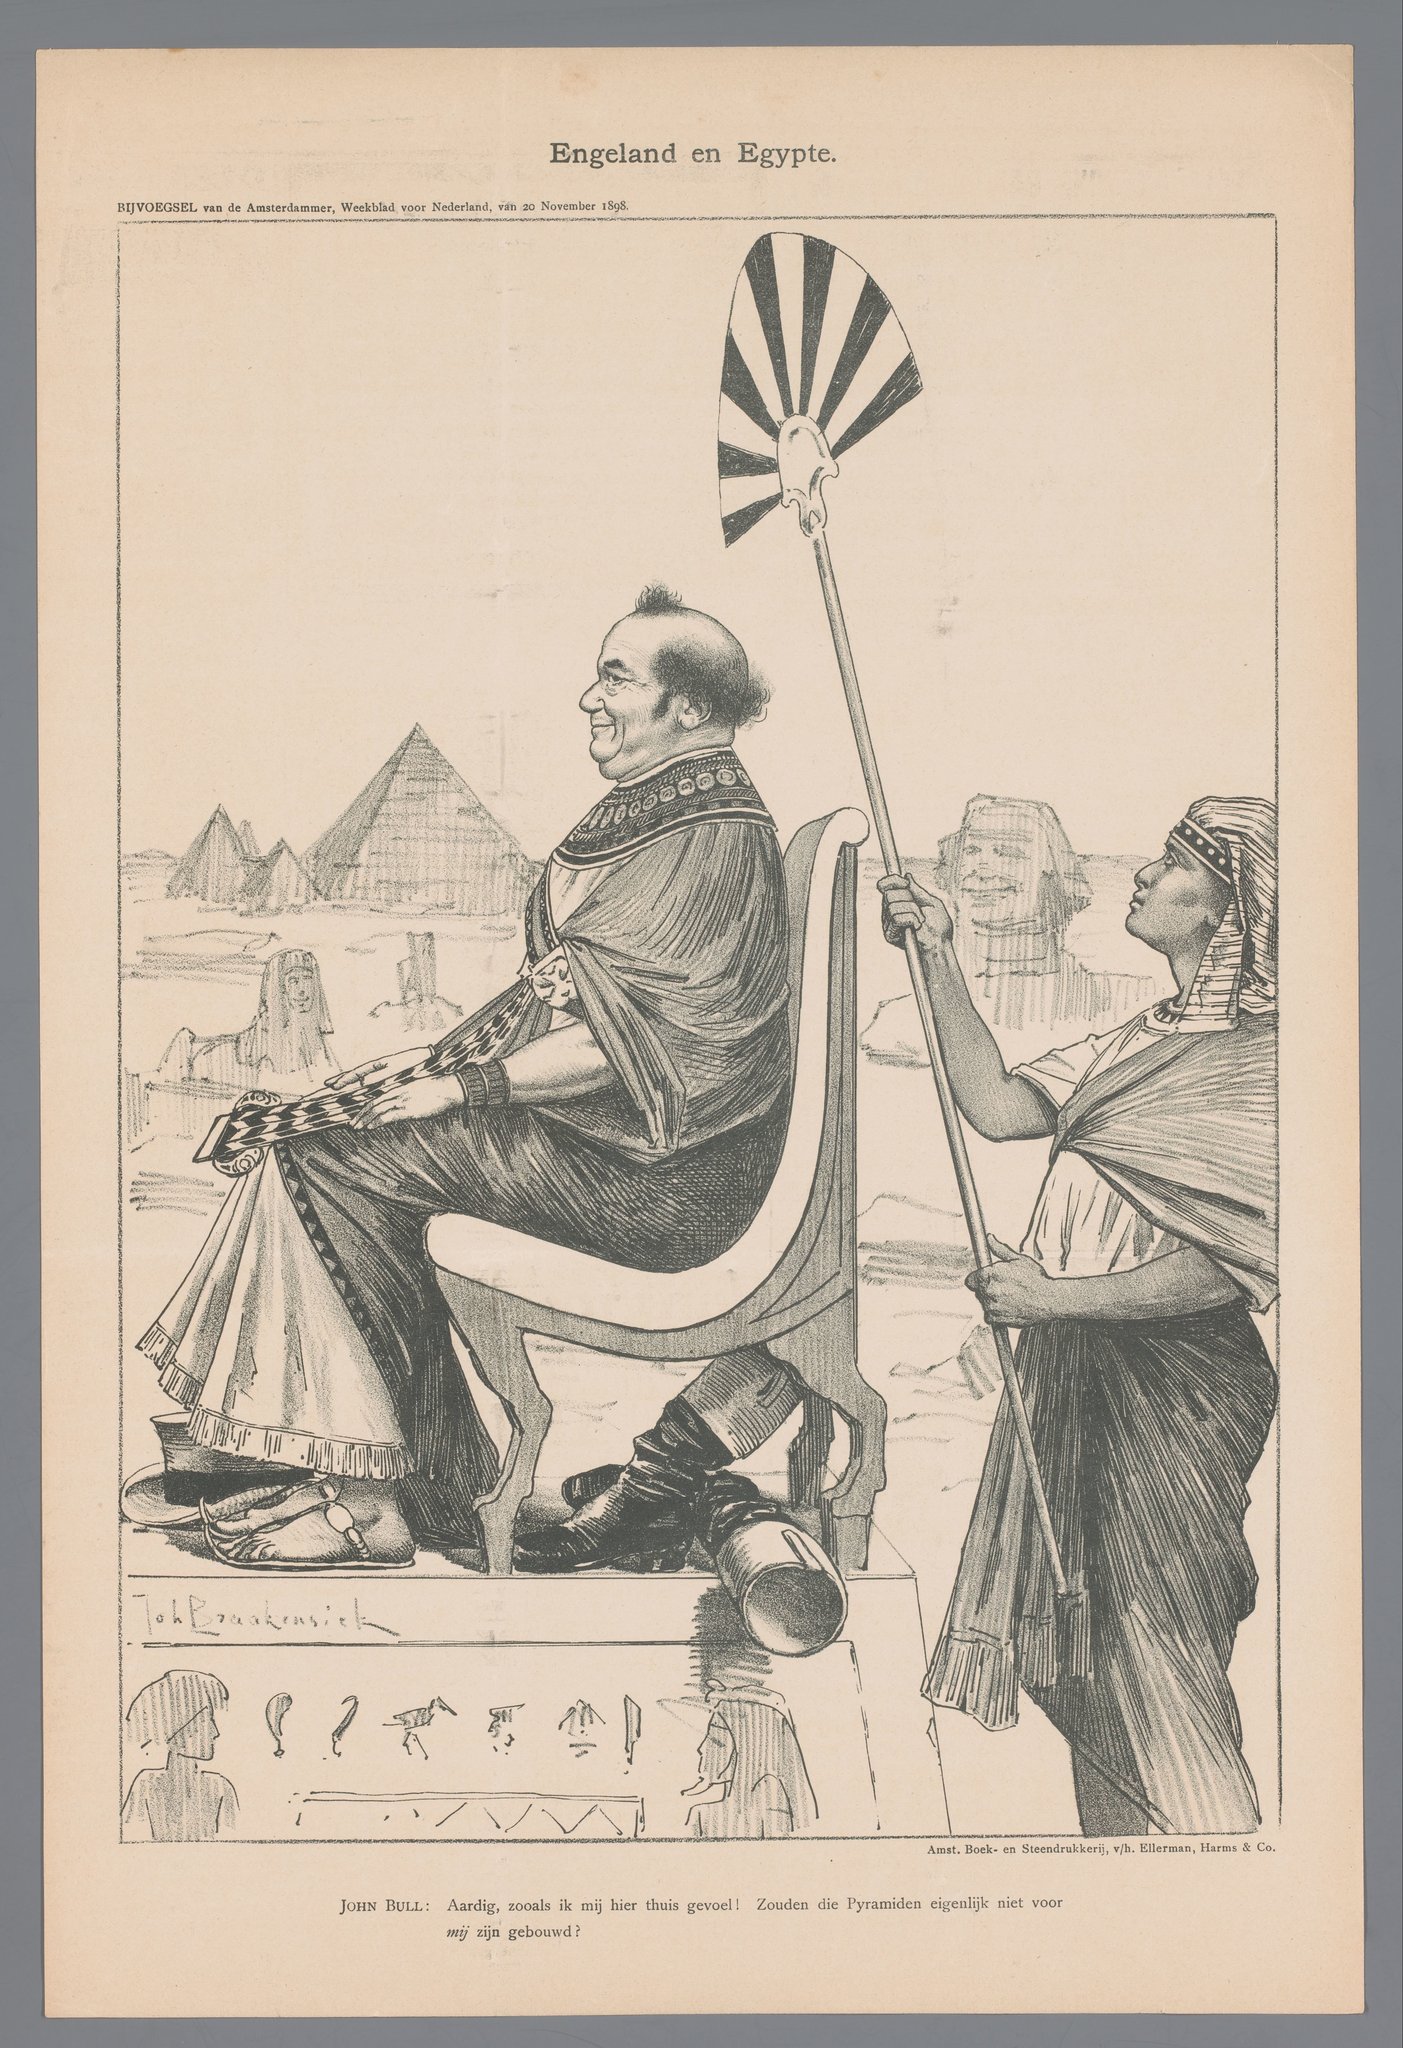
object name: cartoon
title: Engeland en Egypte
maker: johan braakensiek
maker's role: draughtsman, print maker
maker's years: 1858-1940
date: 1898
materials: paper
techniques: lithograph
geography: amsterdam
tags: egyptian pyramids (wonder of the world), personifications of countries, nations, states, districts, etc. (+ nation; national), political caricatures and satires, mahdist war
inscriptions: date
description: Prent uit het bijvoegsel van: De Amsterdammer. Weekblad voor Nederland, 20 november 1898.